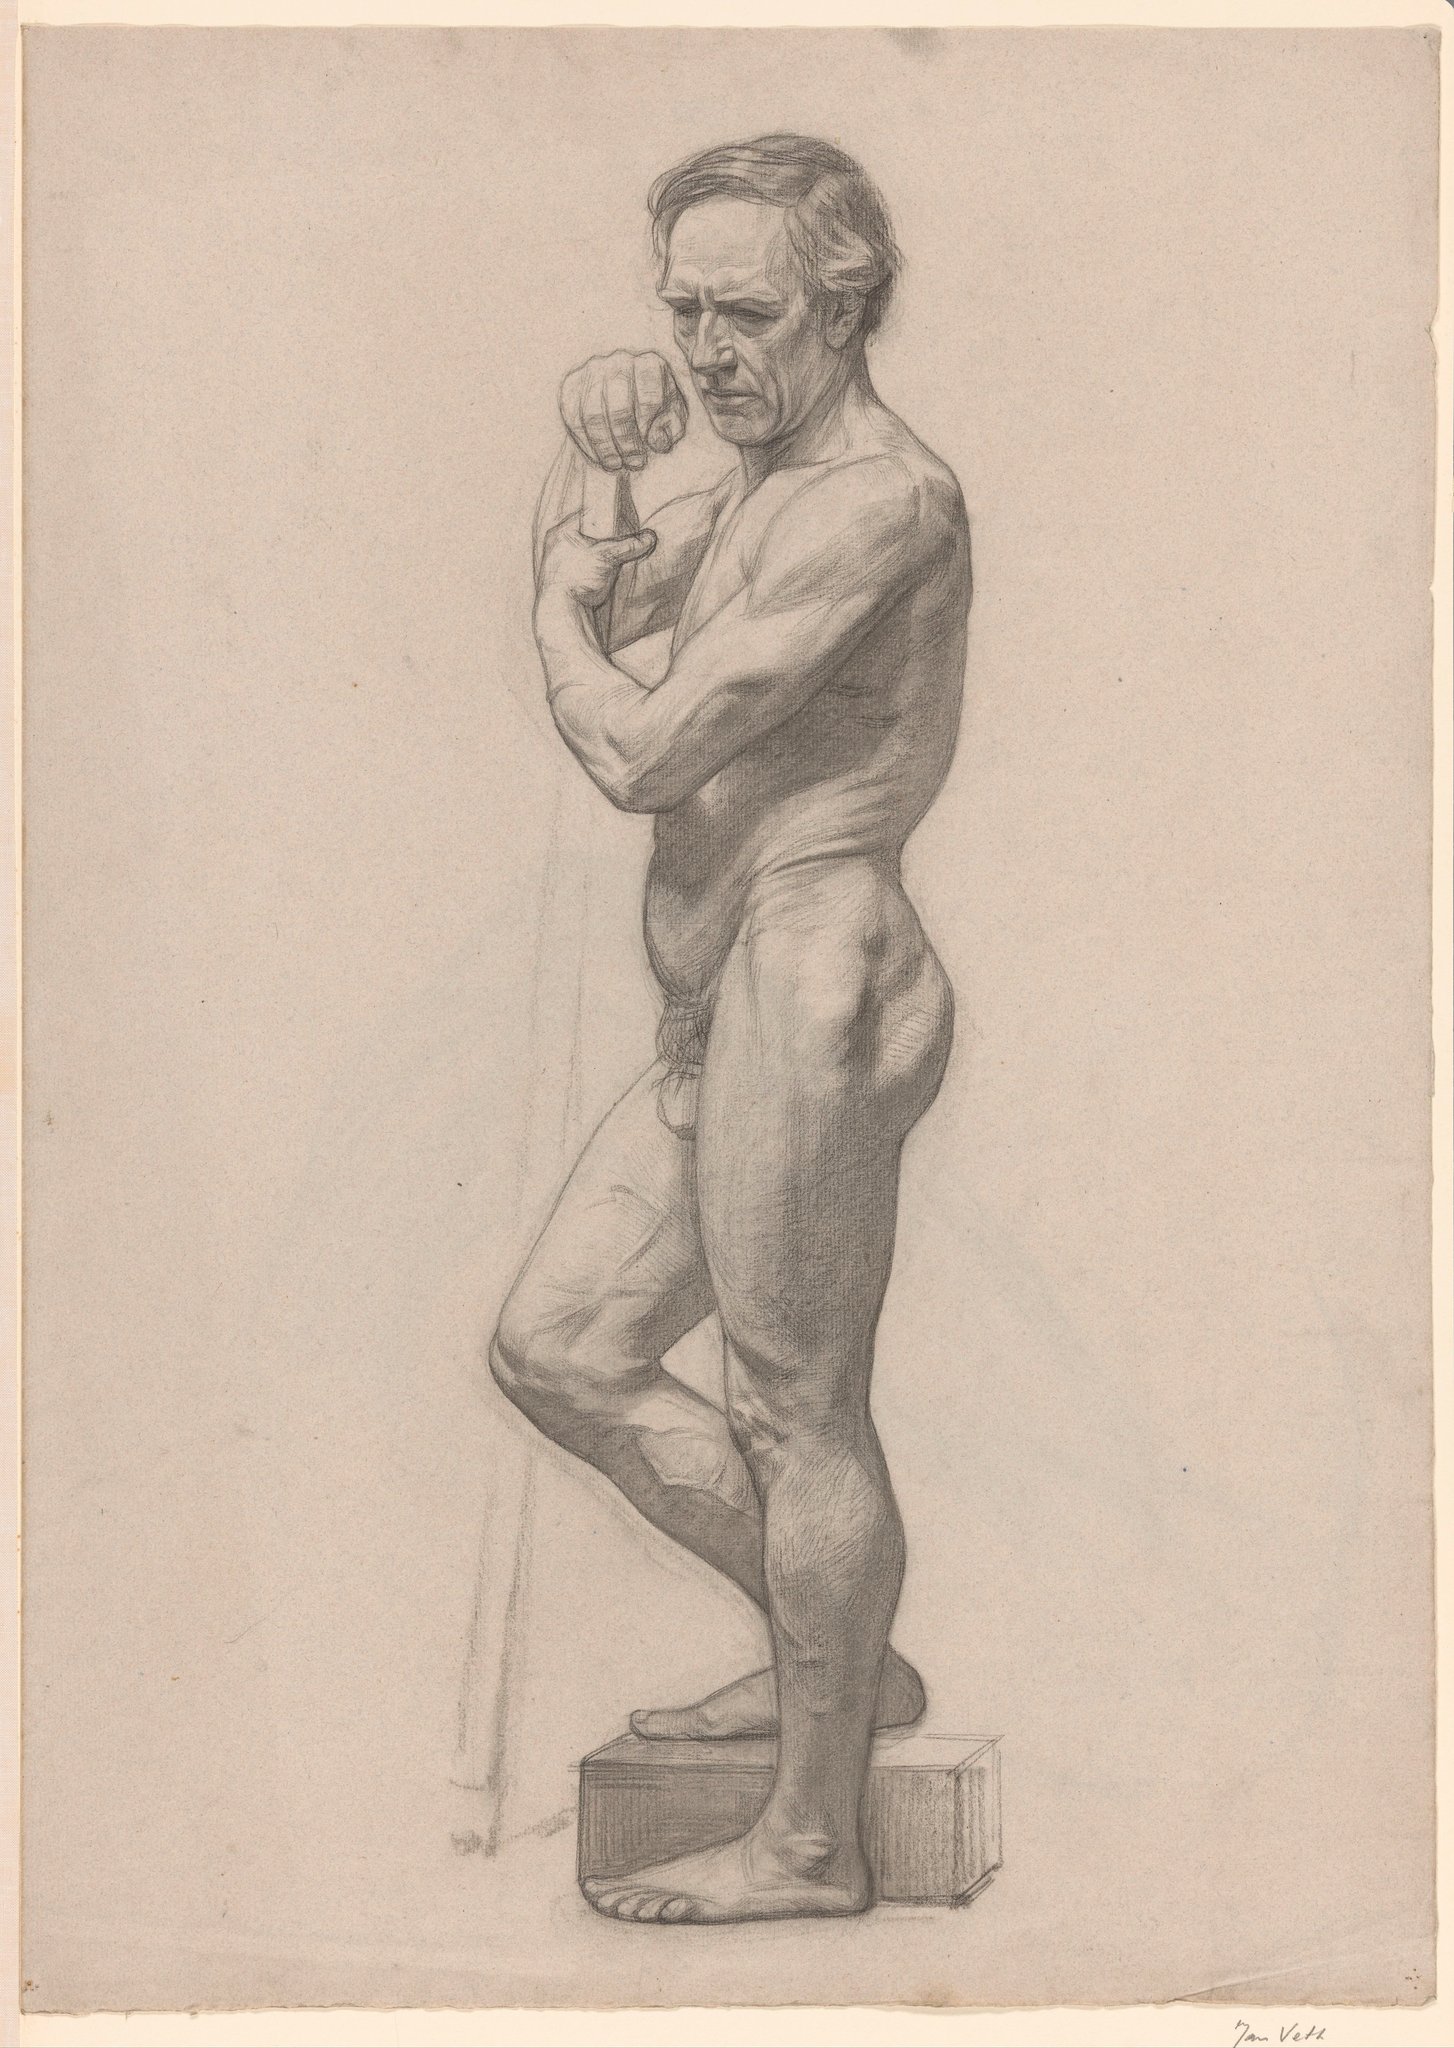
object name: drawing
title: Staand mannelijk naakt, met stok, naar links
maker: jan veth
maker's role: designer, draughtsman, painter, print maker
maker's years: 1864-1925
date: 1874-1925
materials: chalk, paper